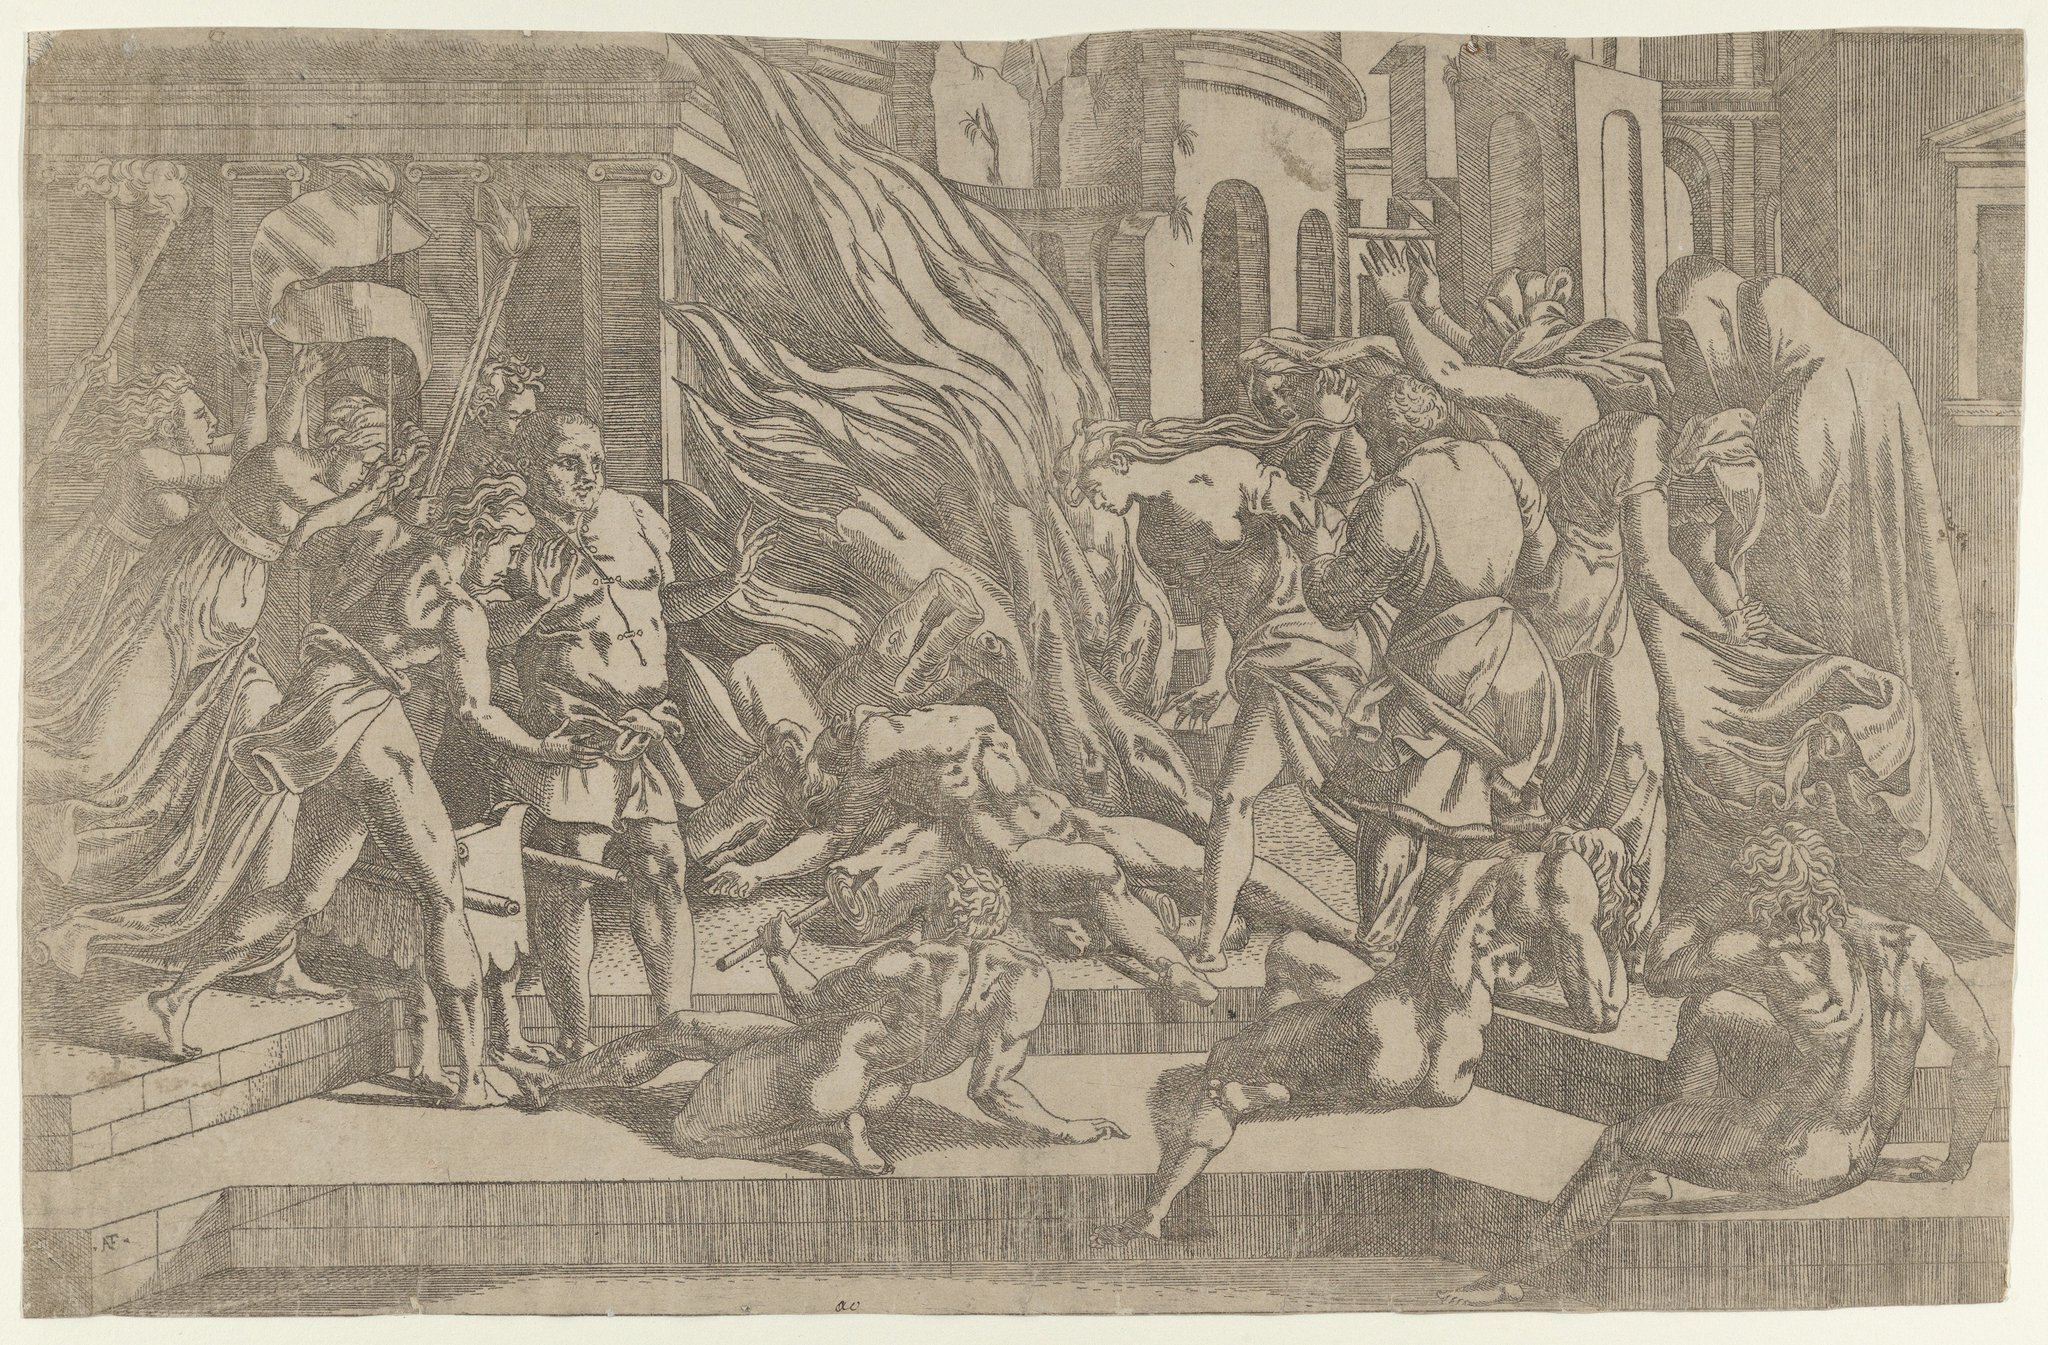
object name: print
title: Burning of a corpse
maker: antonio fantuzzi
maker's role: artist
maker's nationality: italian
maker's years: 1537-1545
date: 1540-1545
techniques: etching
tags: corpses,fires,crowd